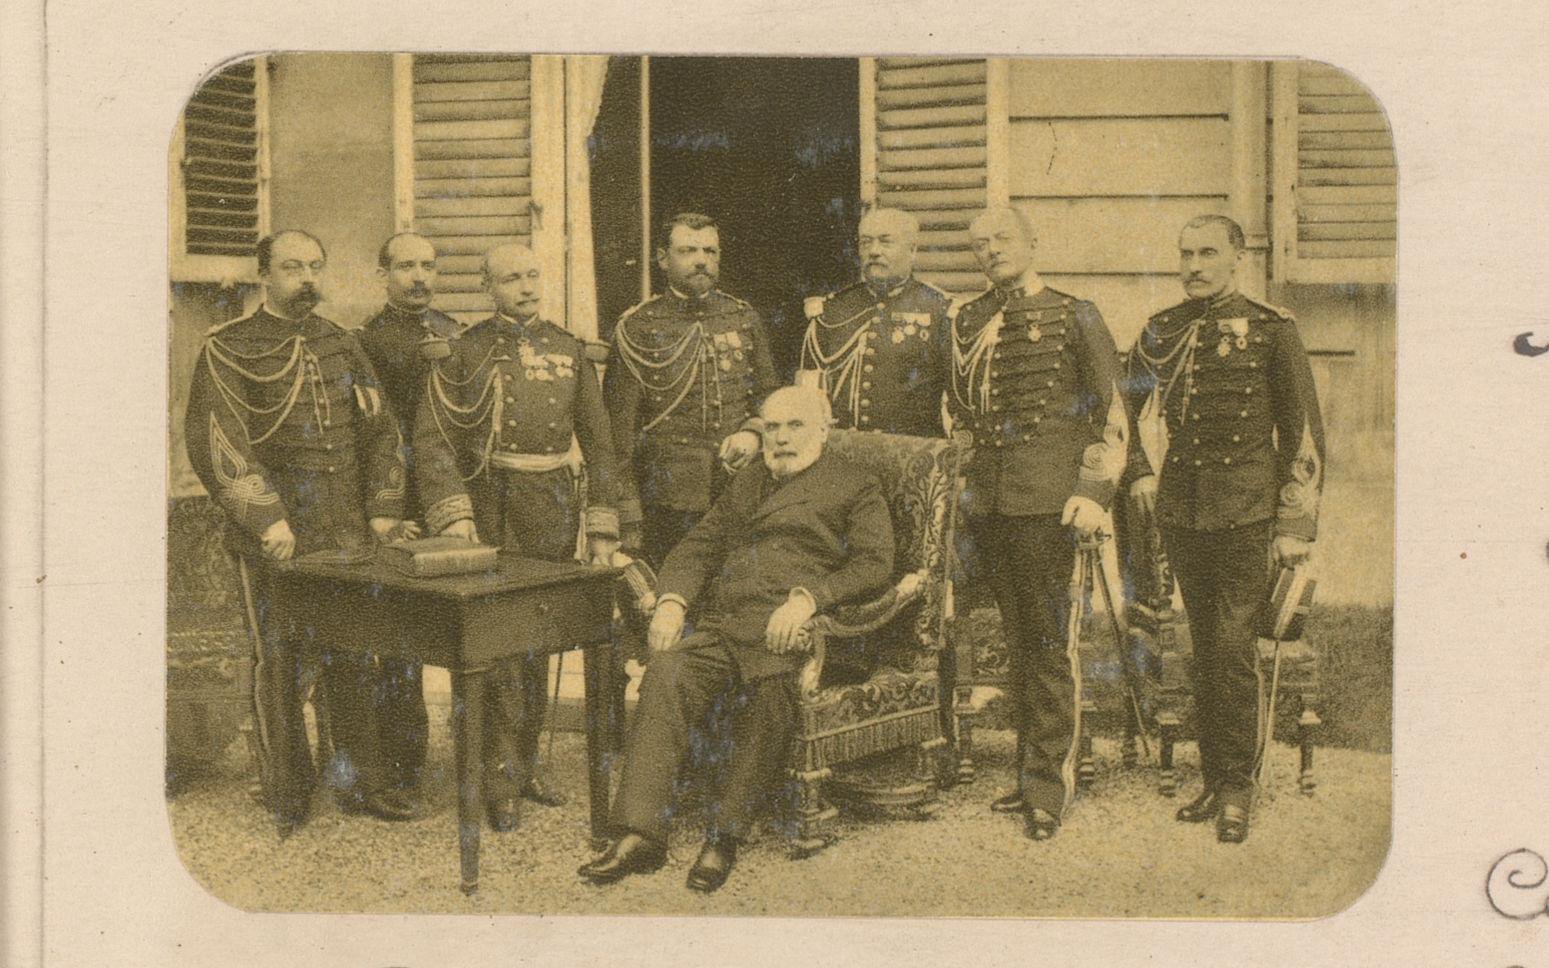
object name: photograph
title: Président Grévy (en 1880)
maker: Anonymous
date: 1880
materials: paper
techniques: rotogravure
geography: france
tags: president ~ head of republic, historical persons, france